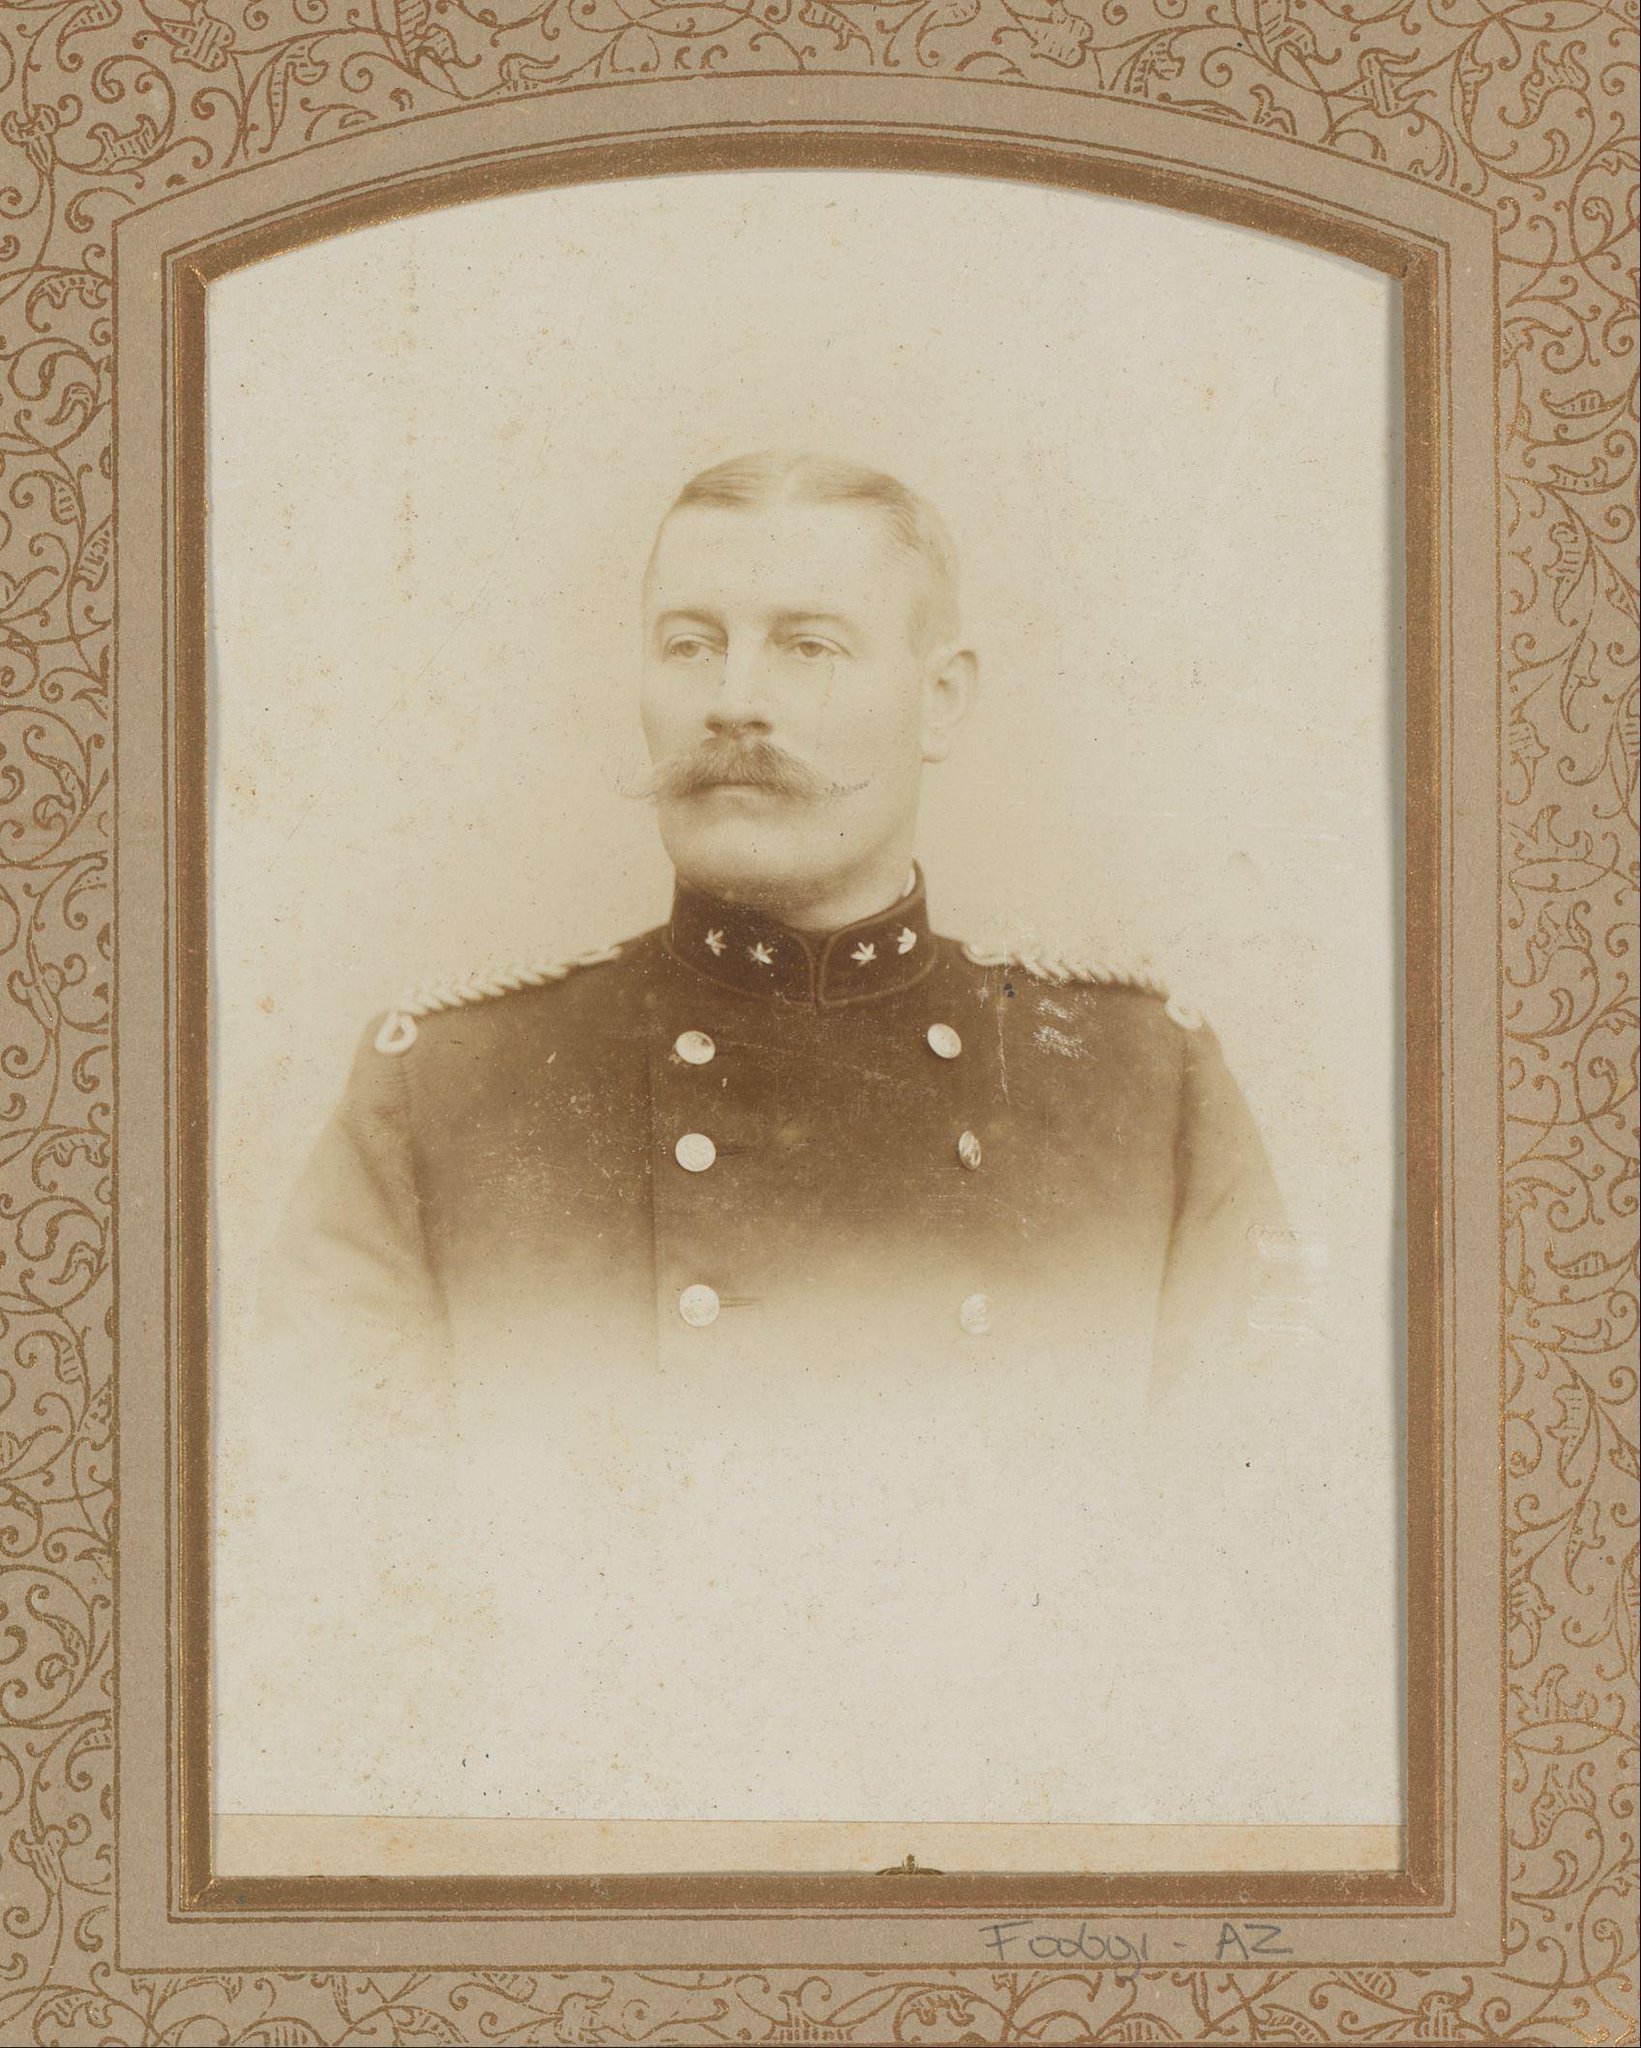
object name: photograph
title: Portret van een man in uniform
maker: j.w. wentzel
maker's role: fotograaf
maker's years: 1855-1930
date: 1890-1898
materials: cardboard, photographic support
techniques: collodion silver print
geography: amersfoort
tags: historical persons, (military) uniforms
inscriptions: inscription: ‘J.W. Wentzel/ Amersfoort/ Langestraat F.12’